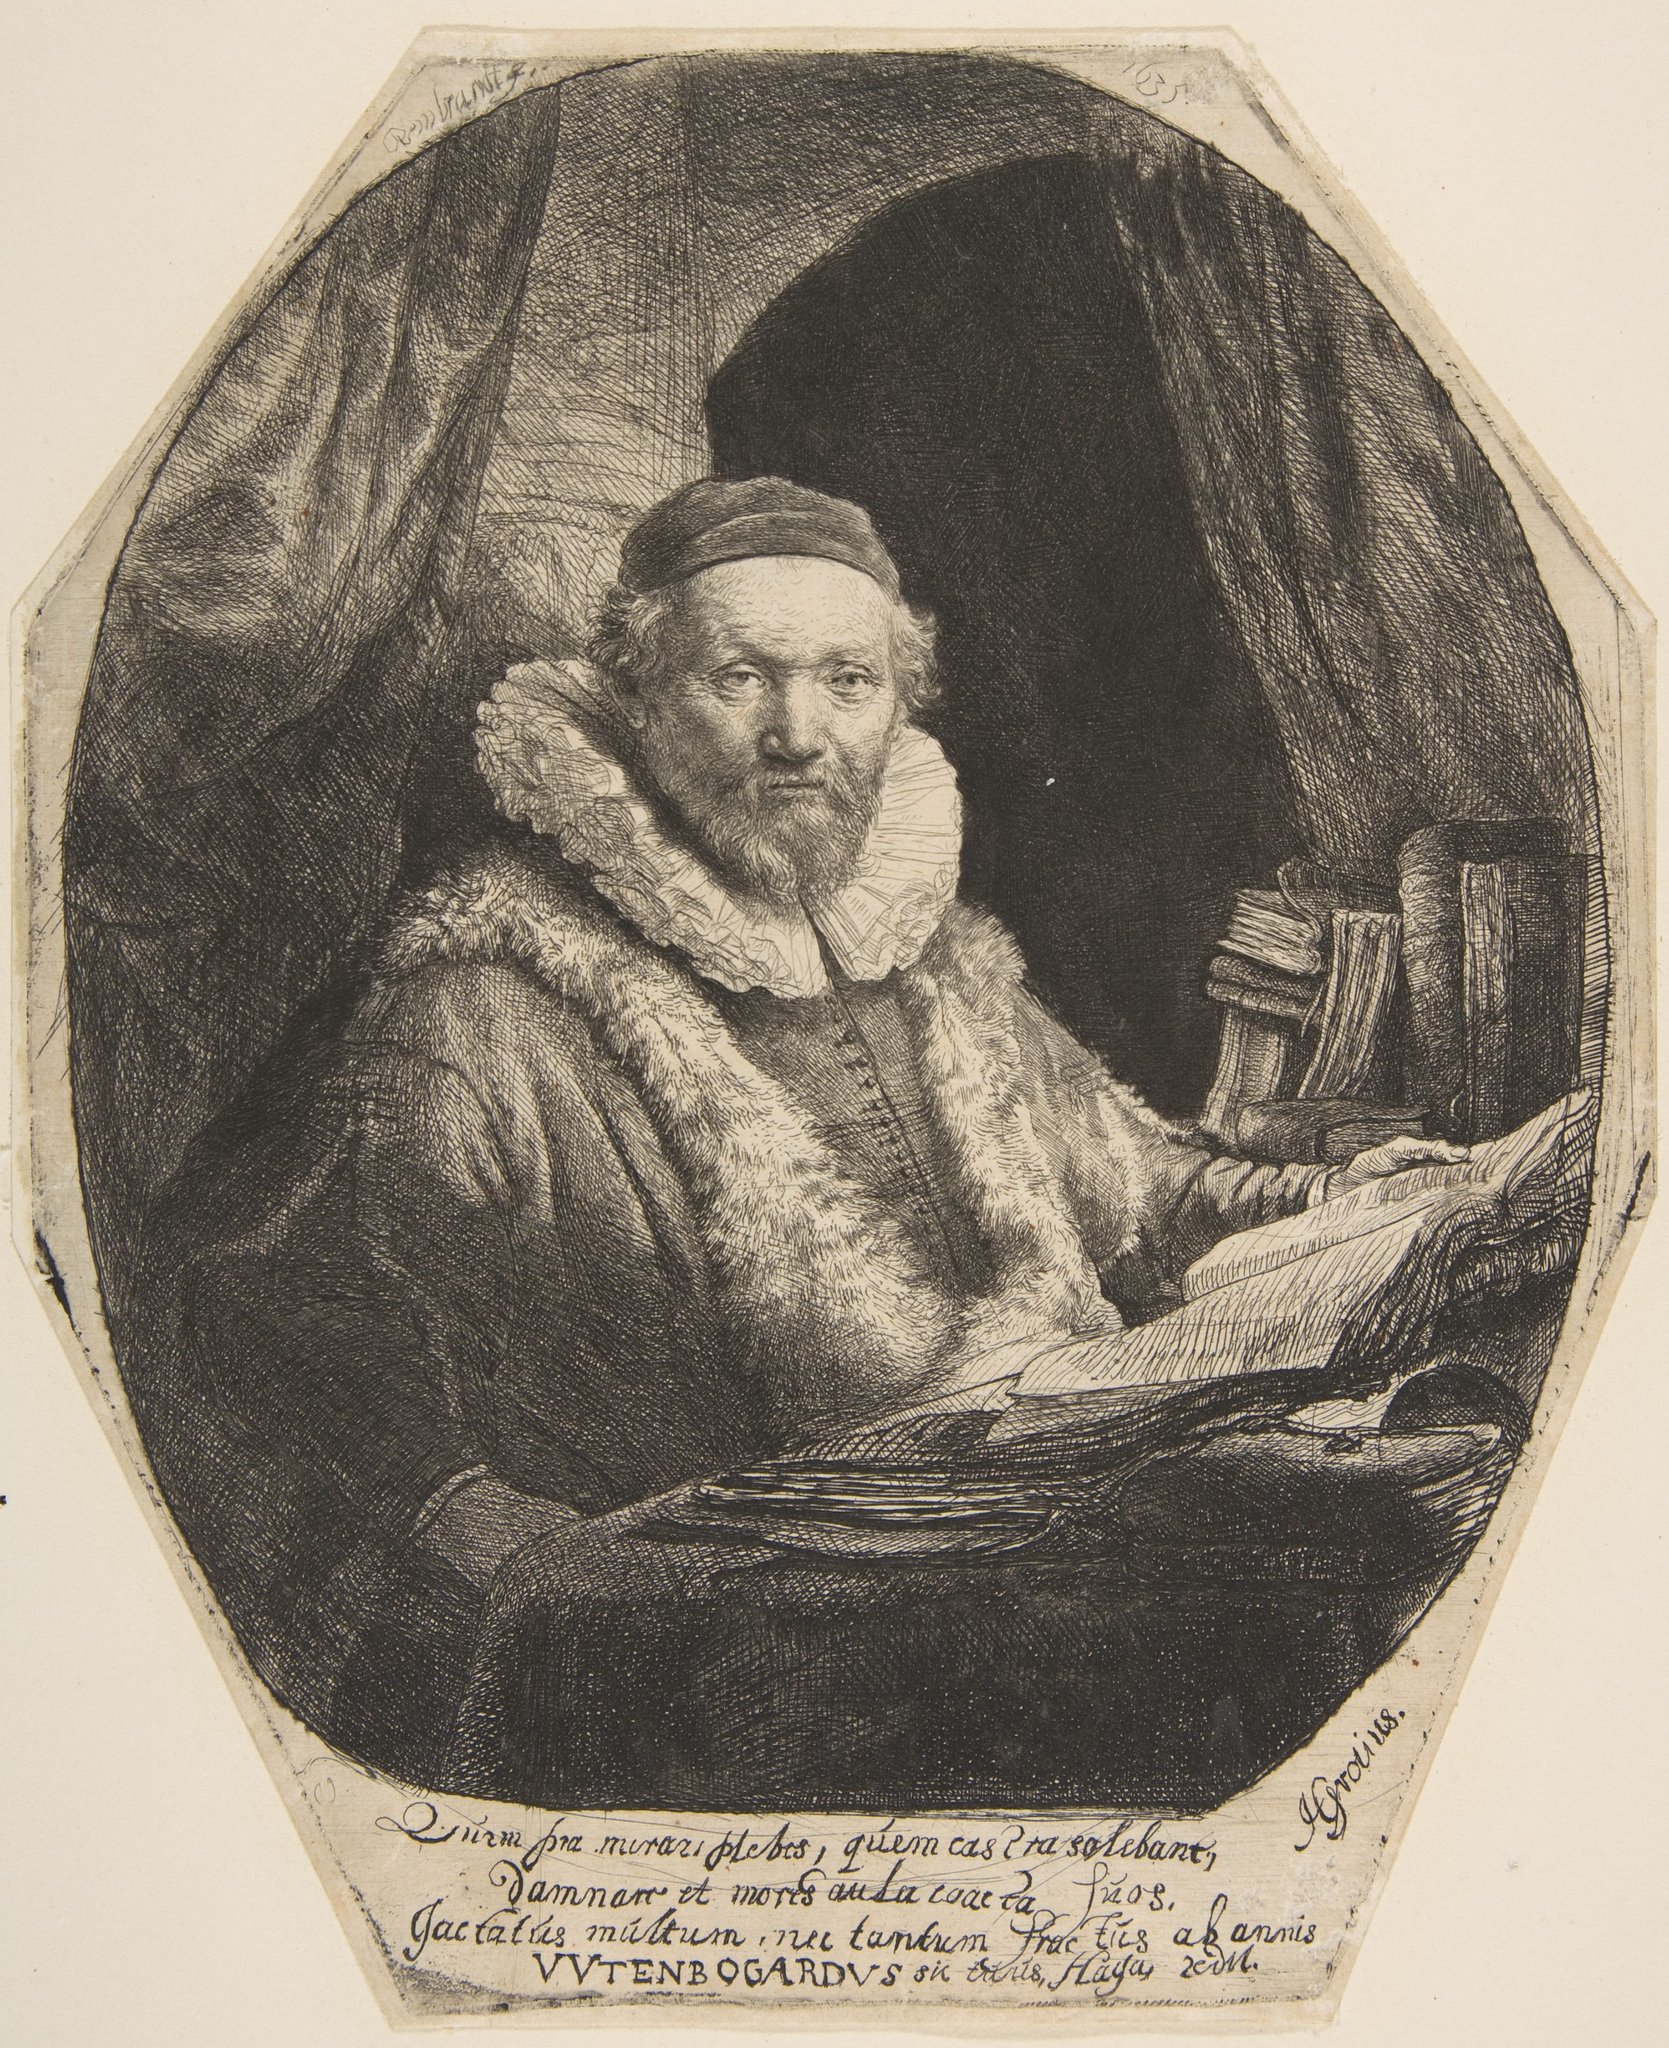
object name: print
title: Jan Uytenbogaert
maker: rembrandt van rijn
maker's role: artist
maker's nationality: dutch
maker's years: 1606-1669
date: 1635-1637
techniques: drypoint, etching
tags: men,portraits